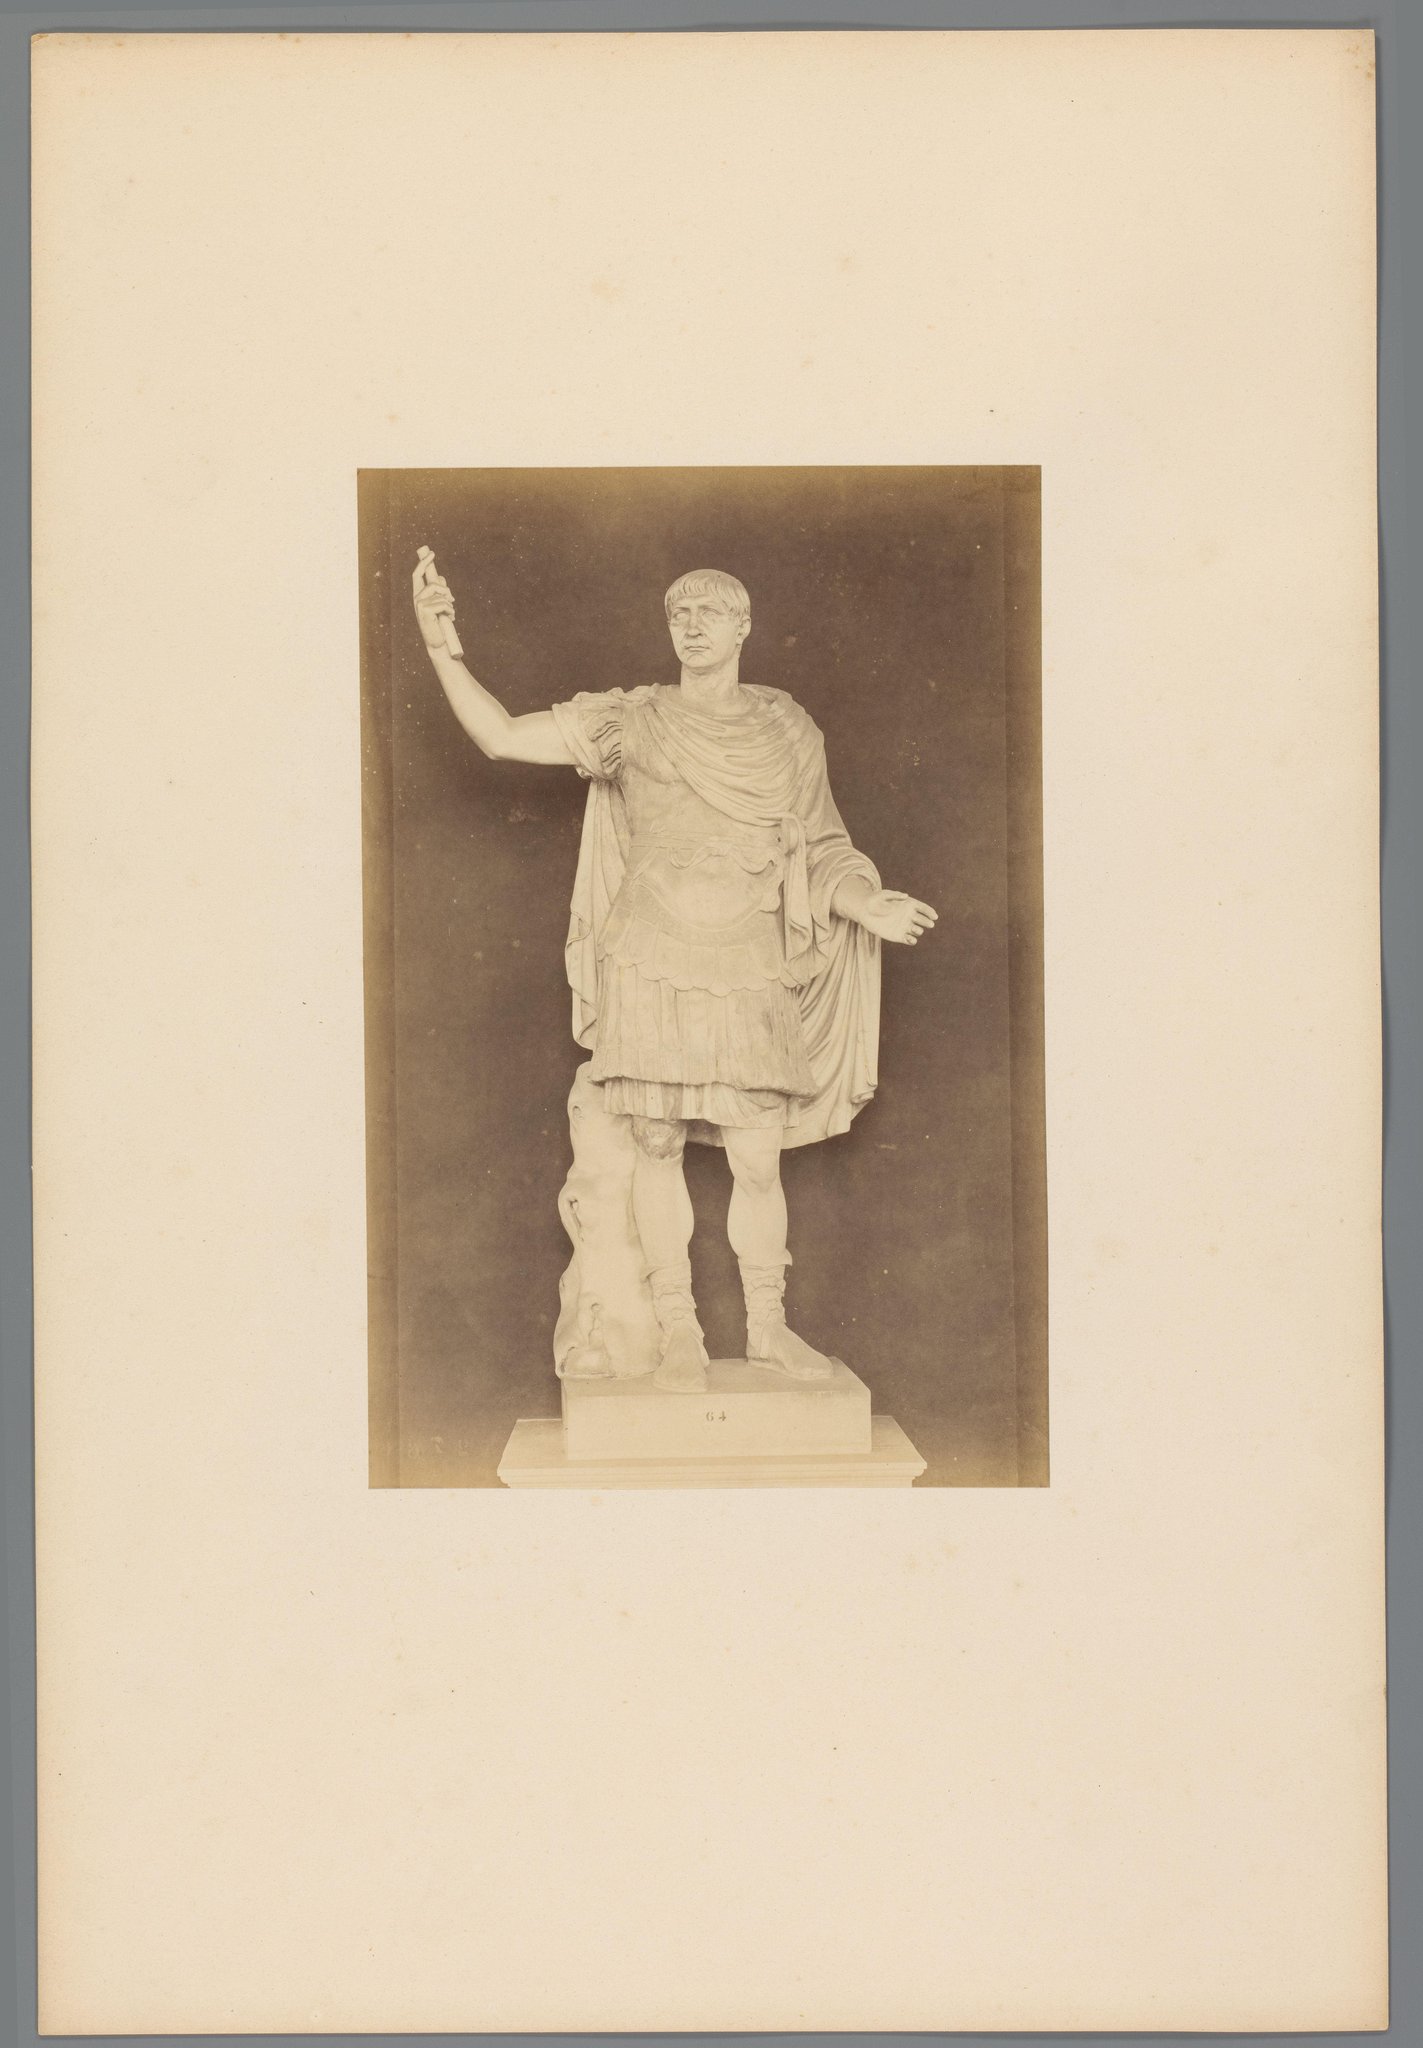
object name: photograph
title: Sculptuur van keizer Trajanus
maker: Anonymous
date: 1851-1900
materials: cardboard, paper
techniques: albumen print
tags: piece of sculpture, reproduction of a piece of sculpture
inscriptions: number: ‘[...]’